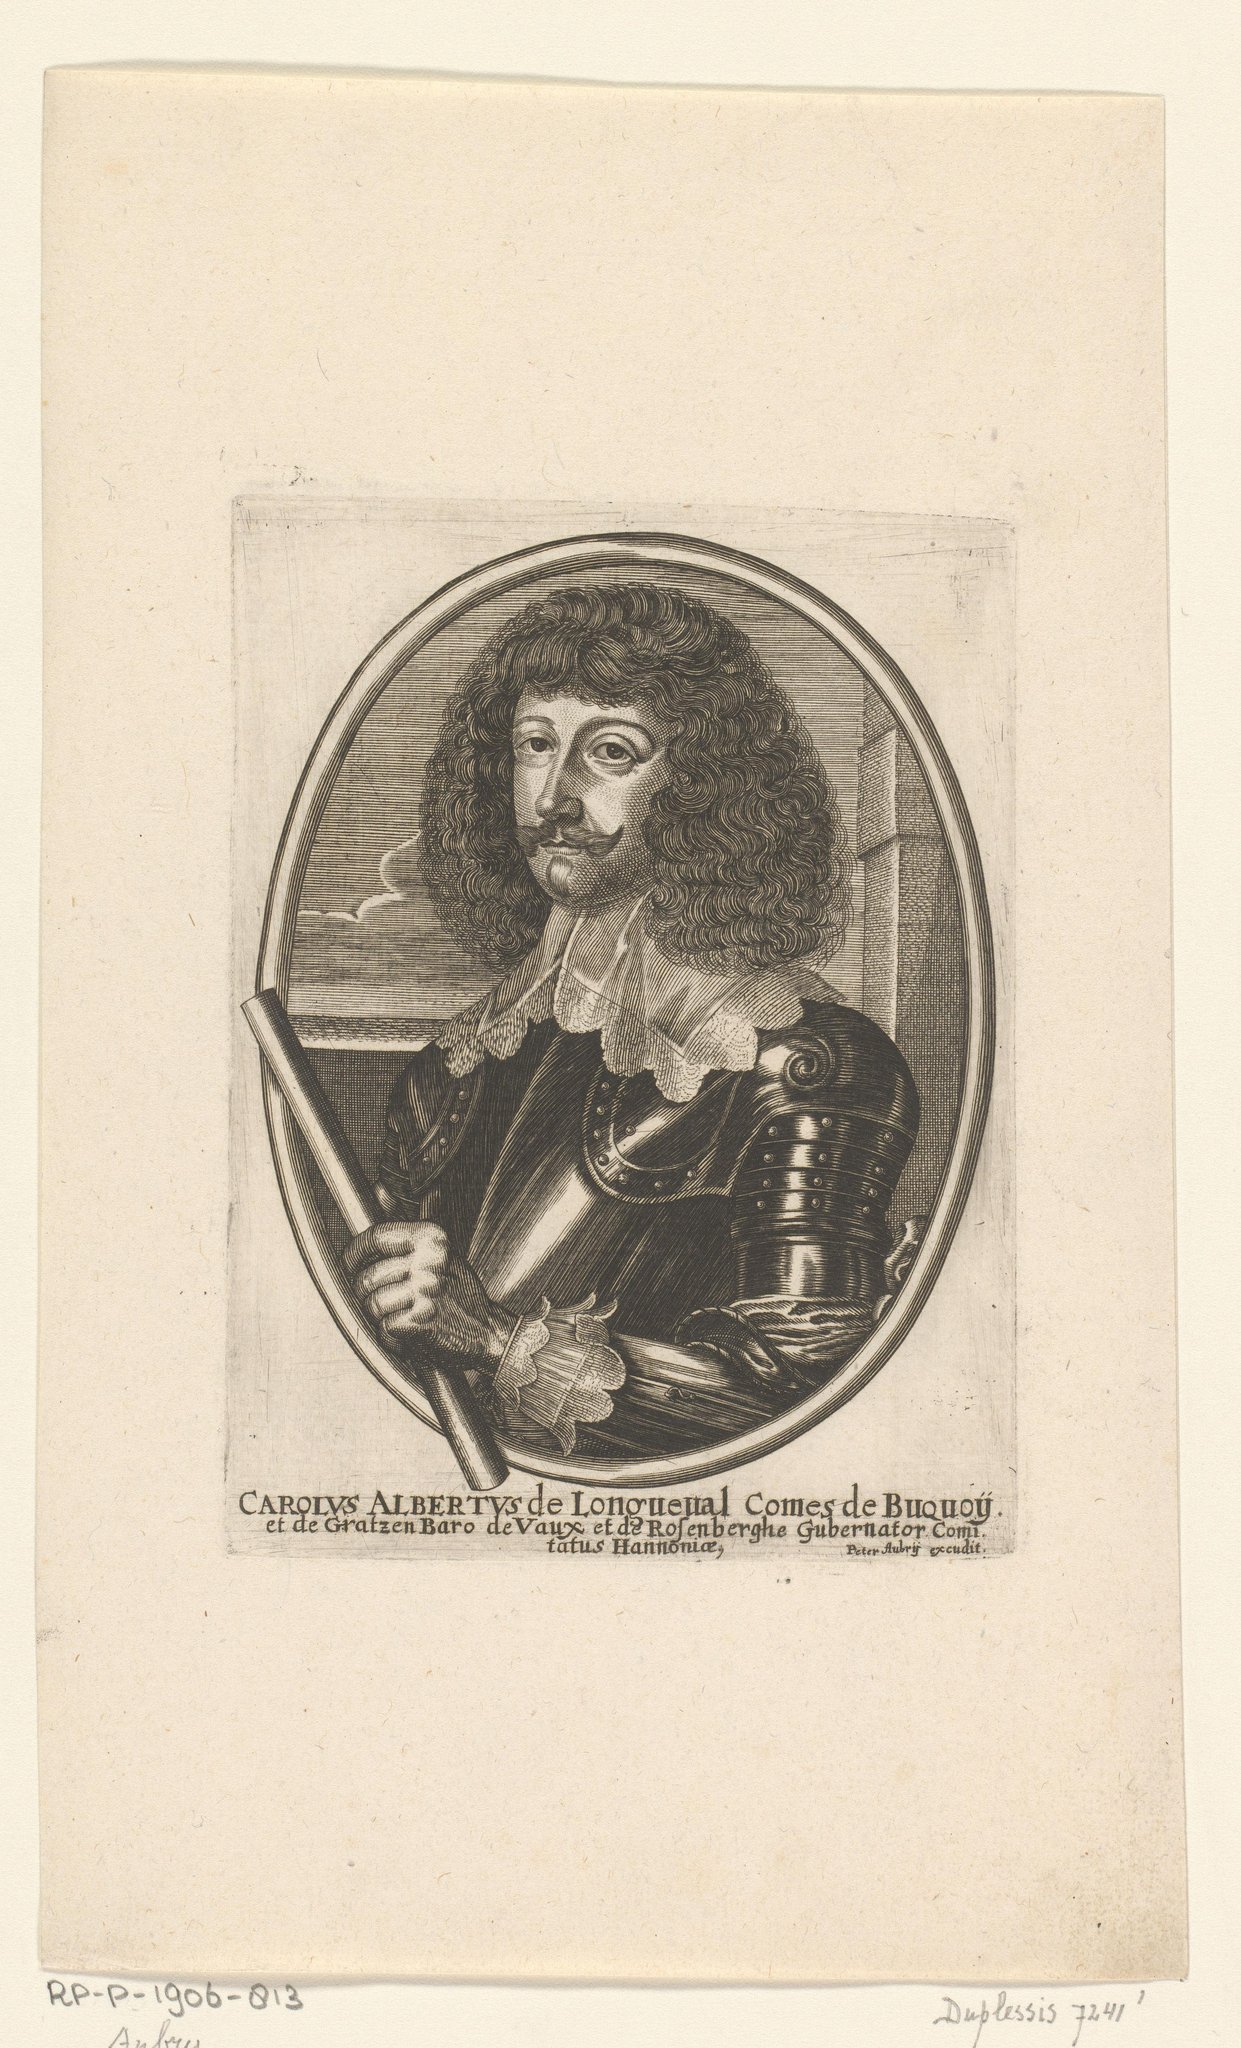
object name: print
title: Portret van Karel Albert de Longueval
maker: Anonymous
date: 1637-1686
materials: paper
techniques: engraving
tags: historical persons, other sovereign (with title)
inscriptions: collector's mark: Lugt 2228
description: Met drieregelig onderschrift in het Latijn.